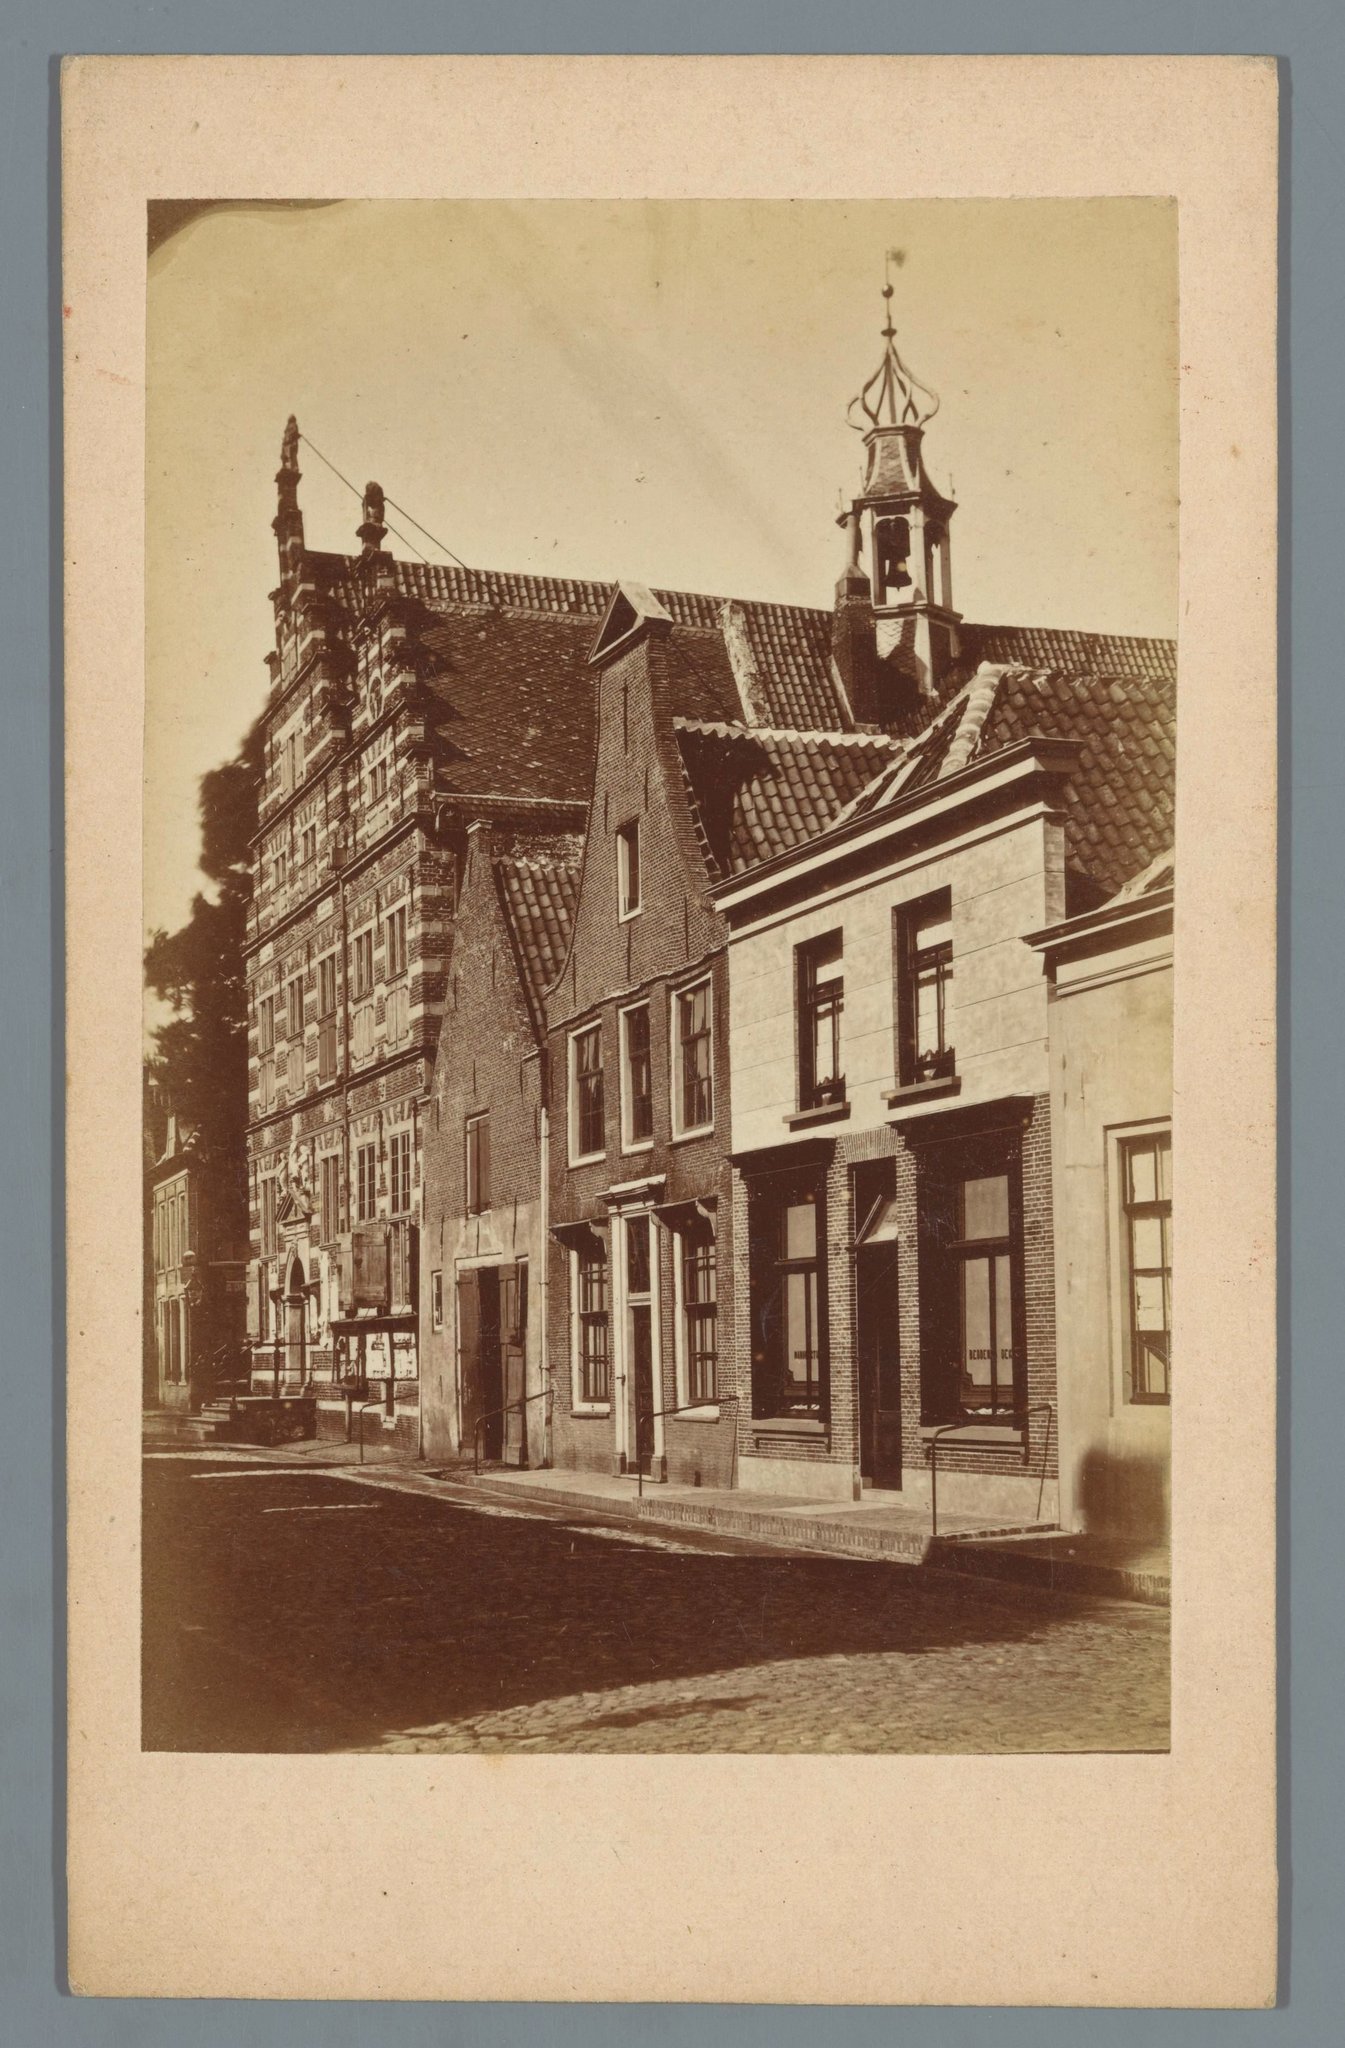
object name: photograph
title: Gezicht op het Stadhuis te Naarden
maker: Anonymous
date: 1850-1900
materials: cardboard, photographic support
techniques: albumen print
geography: naarden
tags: townhall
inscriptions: inscription: ‘Naarden/ Stadhuis’